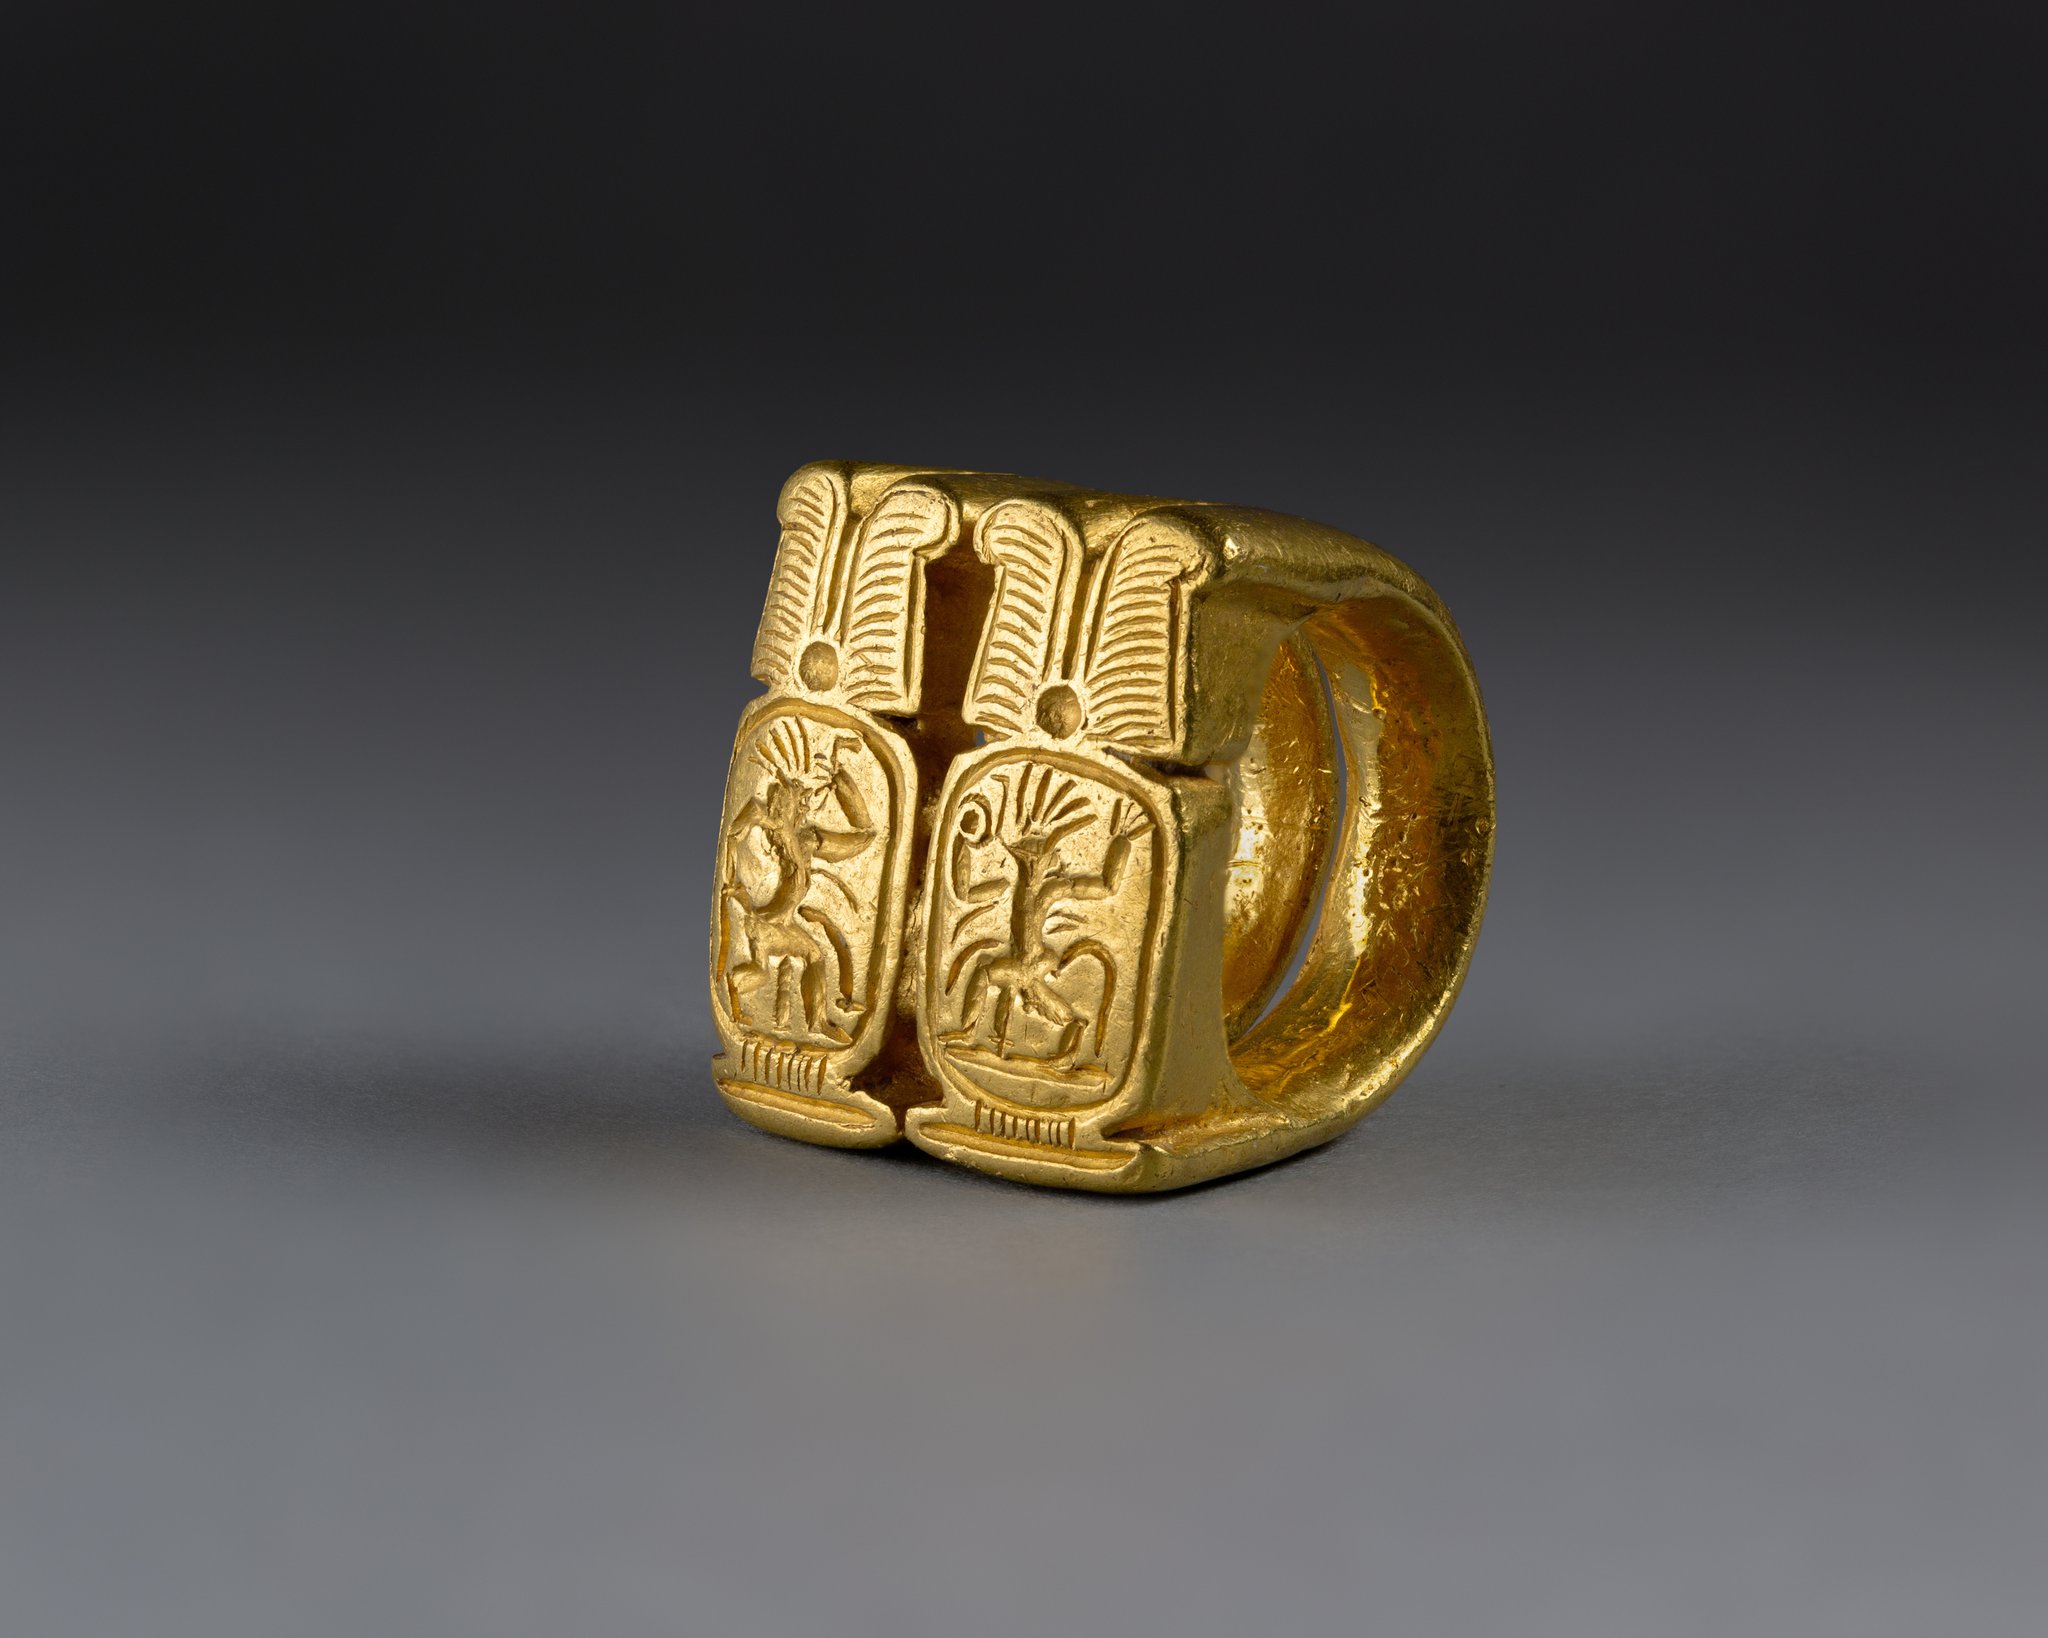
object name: ring, signet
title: Signet ring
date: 1353-1323 BCE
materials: gold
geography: middle egypt